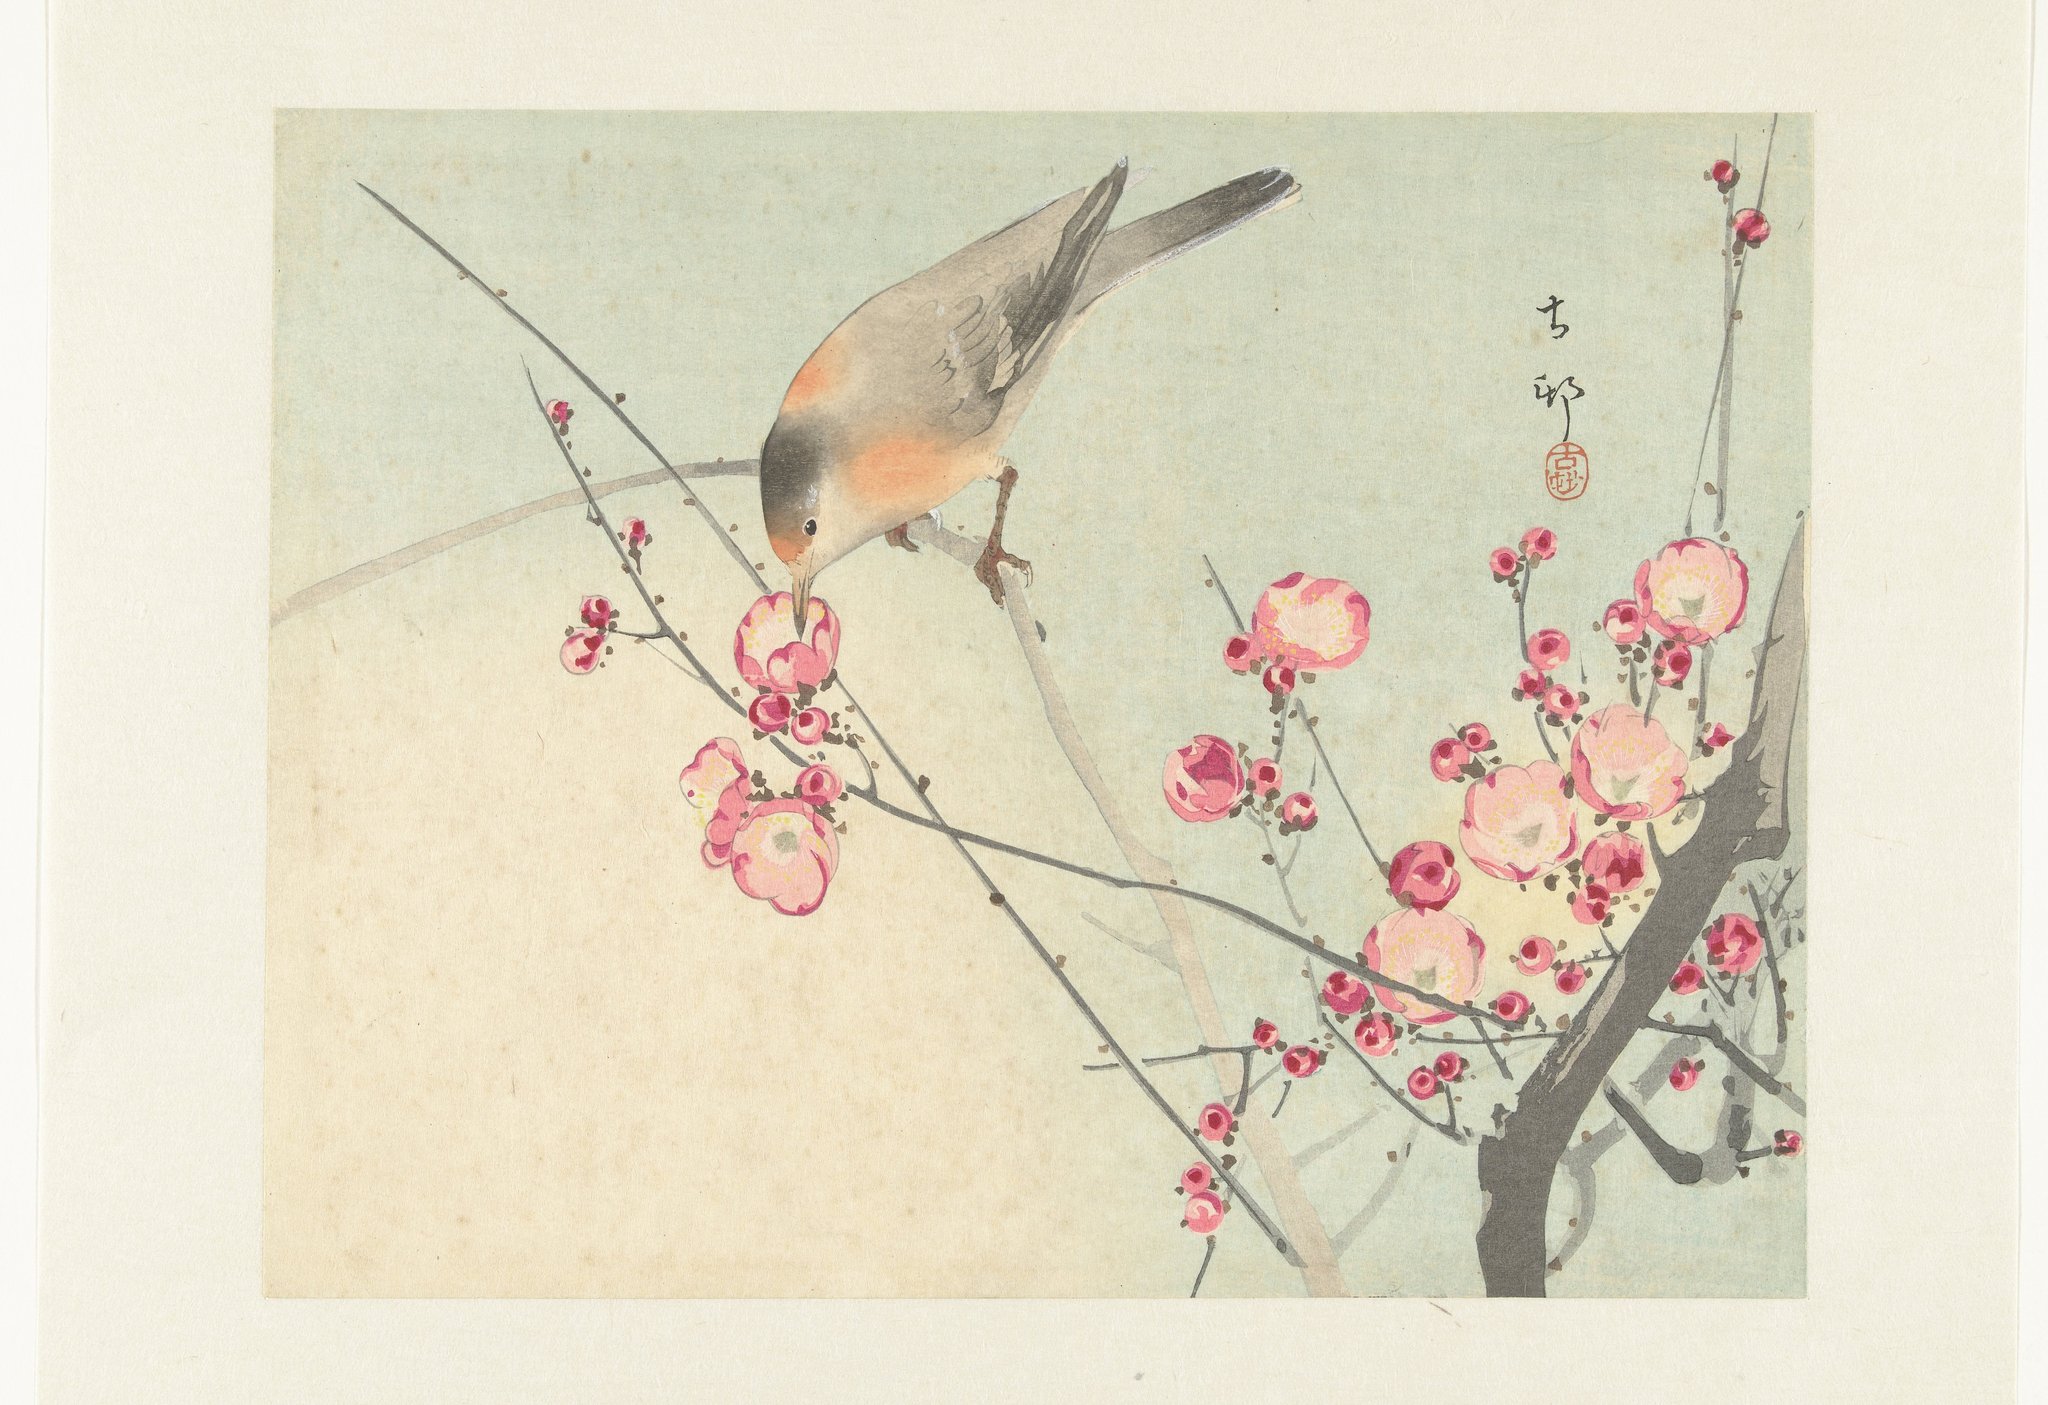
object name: print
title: Zangvogel op bloesemtak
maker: ohara koson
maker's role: print maker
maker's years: 1877-1945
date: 1900-1936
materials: paper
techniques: woodcut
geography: japan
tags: flowers, birds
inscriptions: collector's mark: Lugt 2228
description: Grijs-oranje vogel, naar links, op tak met roze pruimenbloesem